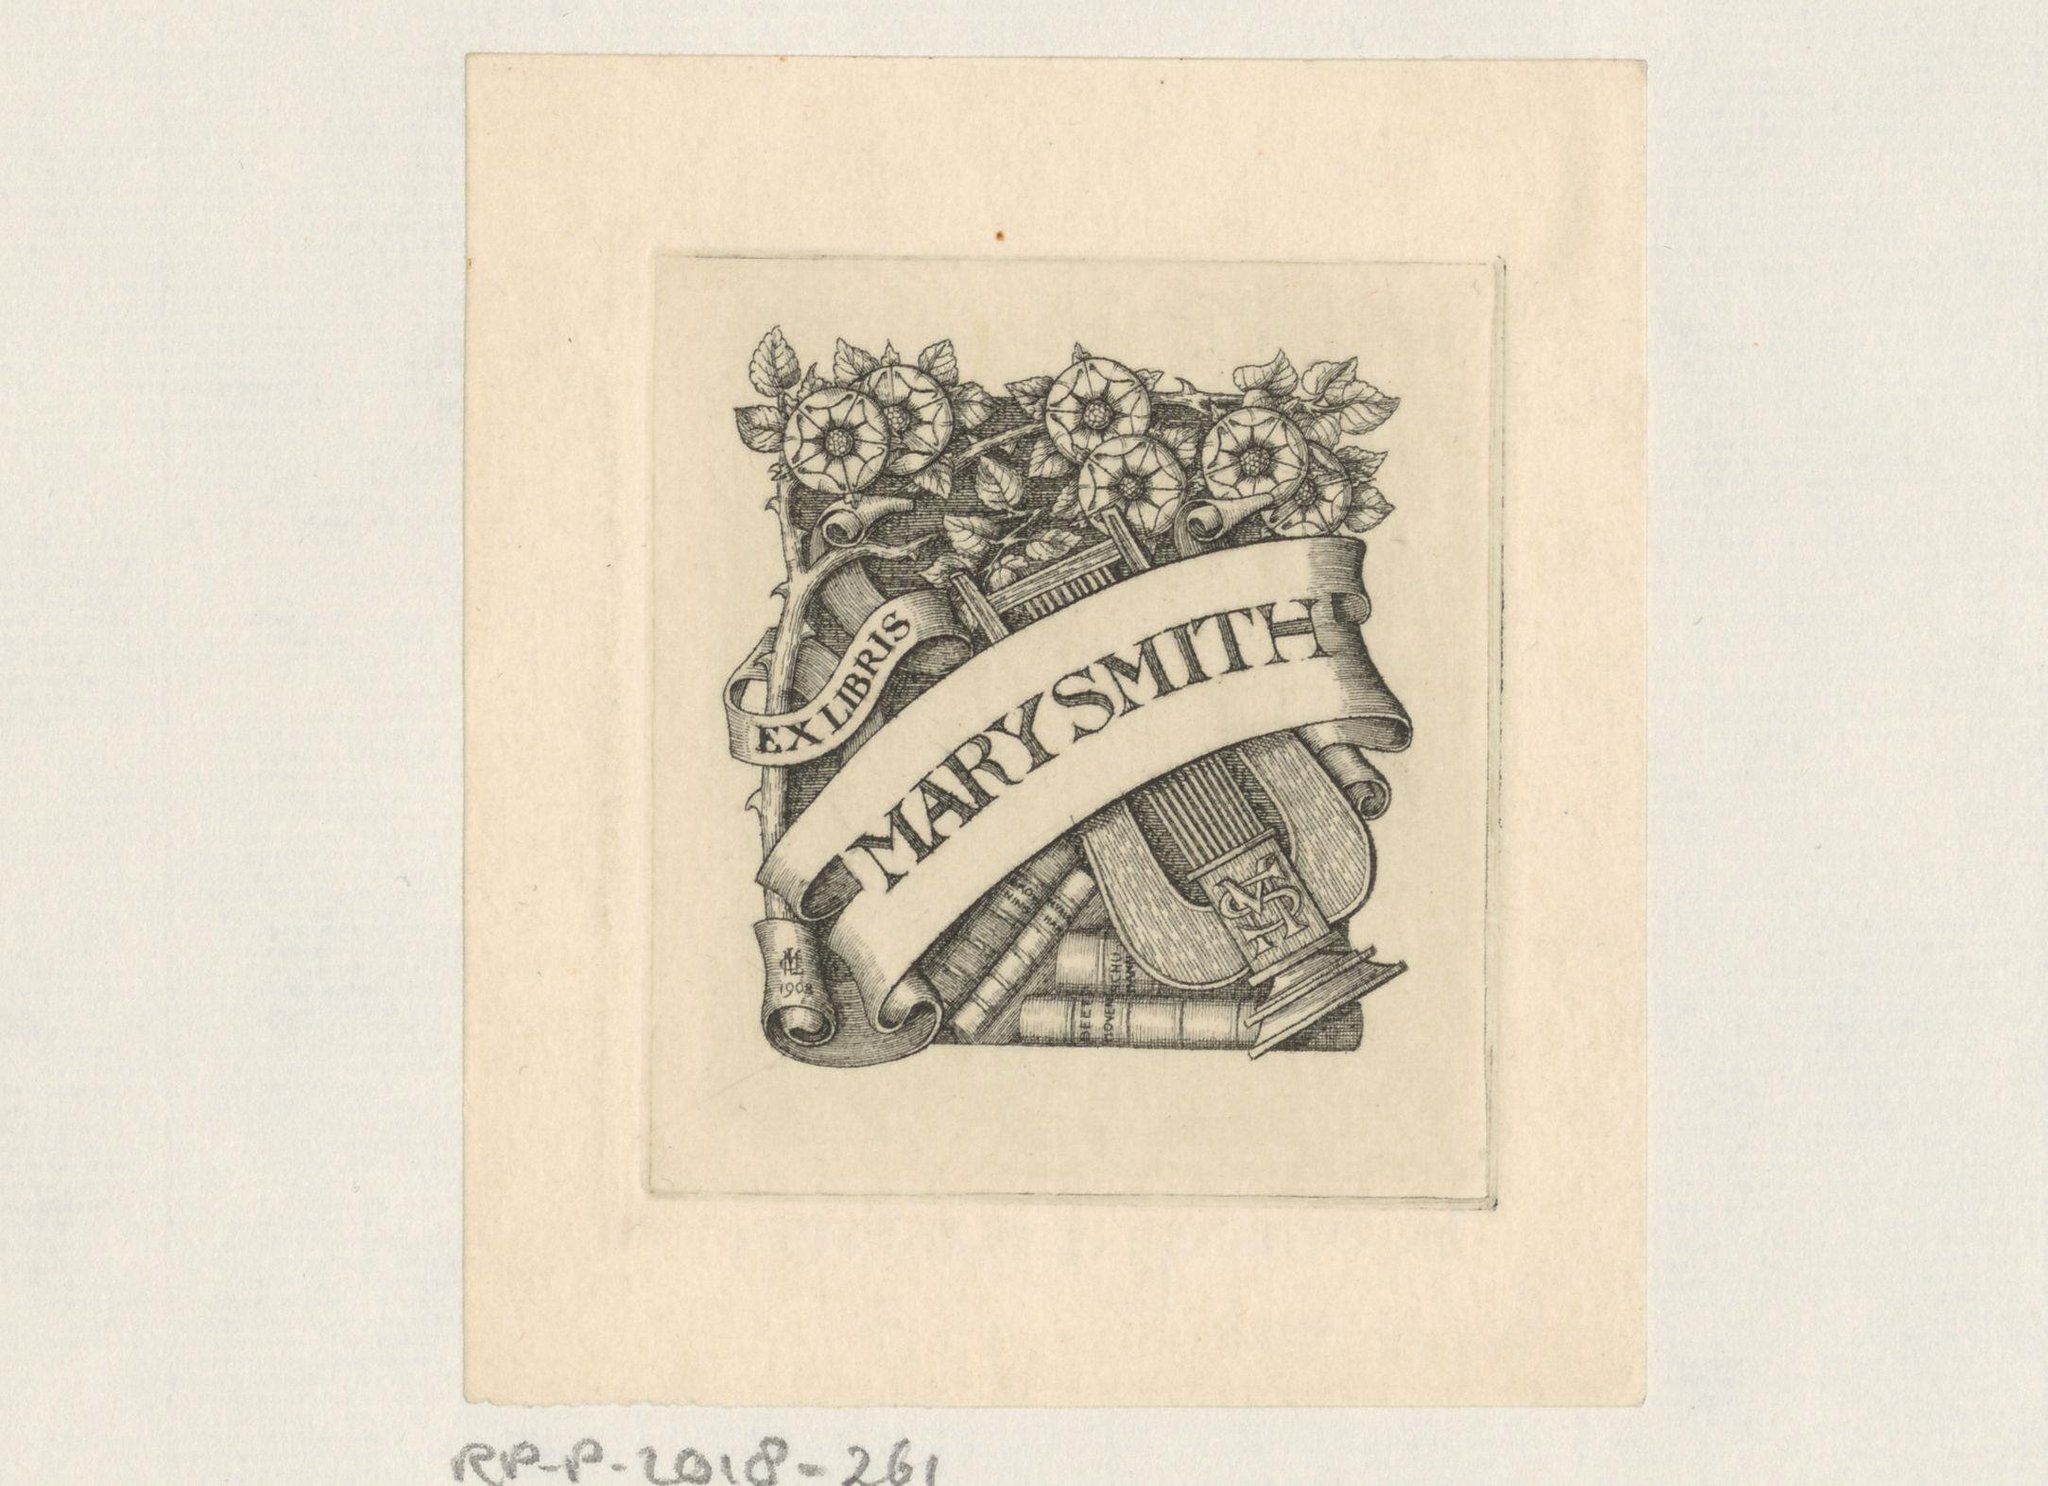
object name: bookplate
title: Ex libris van Mary Smith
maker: mary larison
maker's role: print maker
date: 1908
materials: paper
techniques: etching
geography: england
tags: flowers, lyre, cithara, psaltery, book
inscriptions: inscription: ‘By Mary Larison/ Aug. 18 1908 7217’